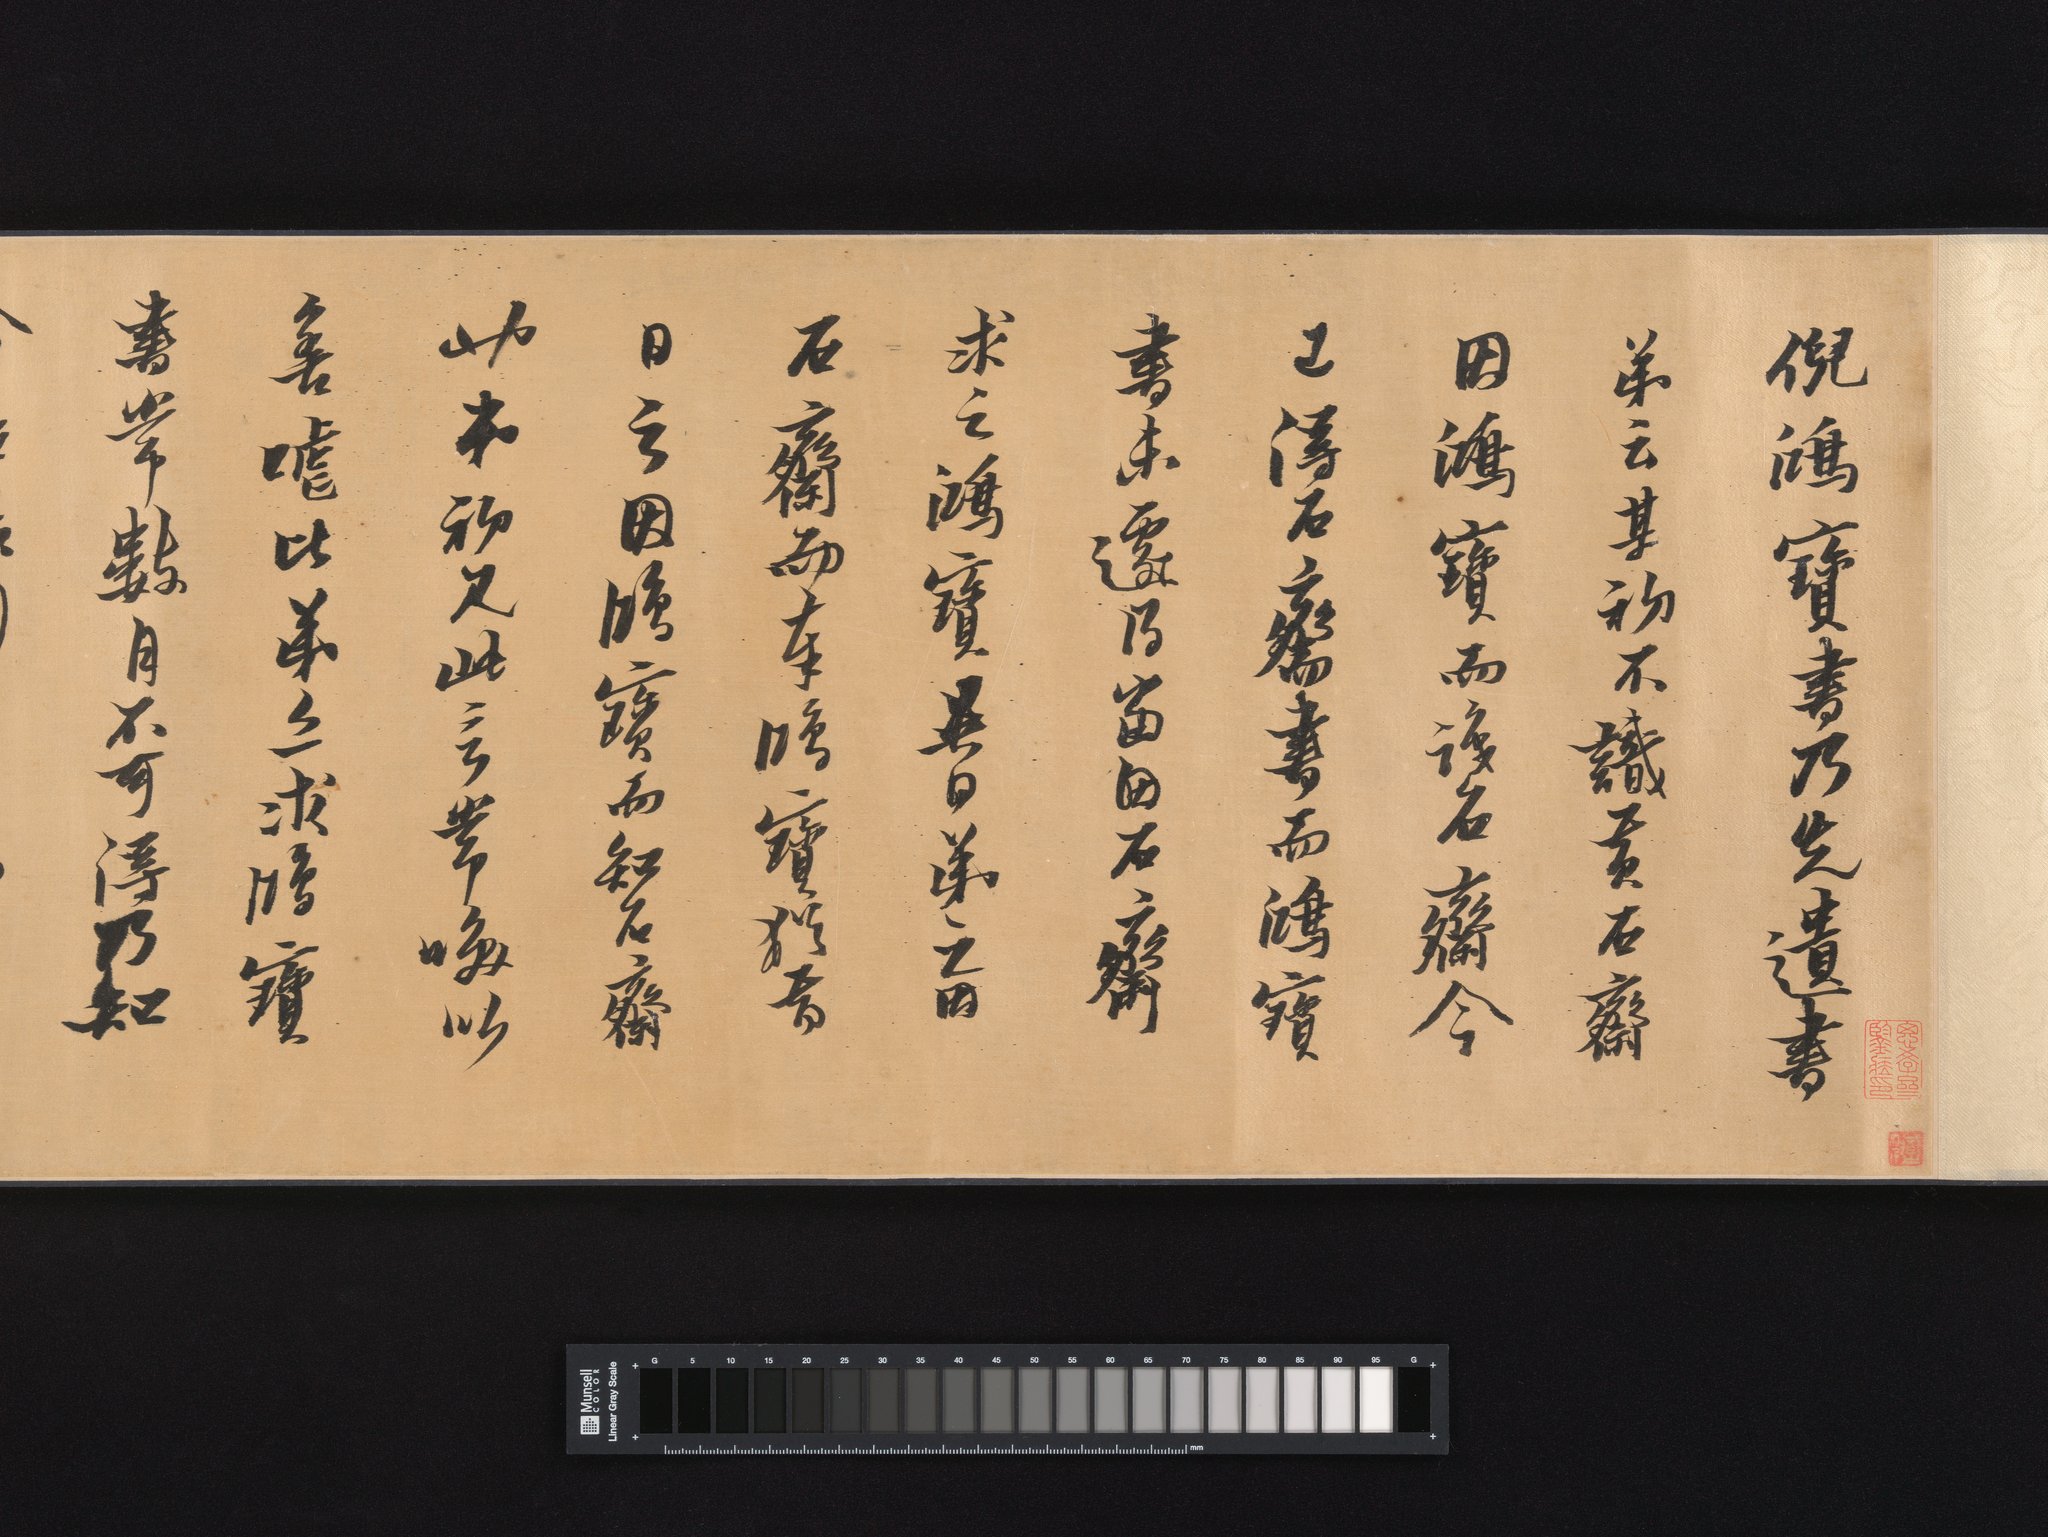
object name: handscroll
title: Joint calligraphy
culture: chinese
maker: huang daozhou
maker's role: artist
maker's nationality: chinese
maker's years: 1585-1646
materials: ink, textile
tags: calligraphy